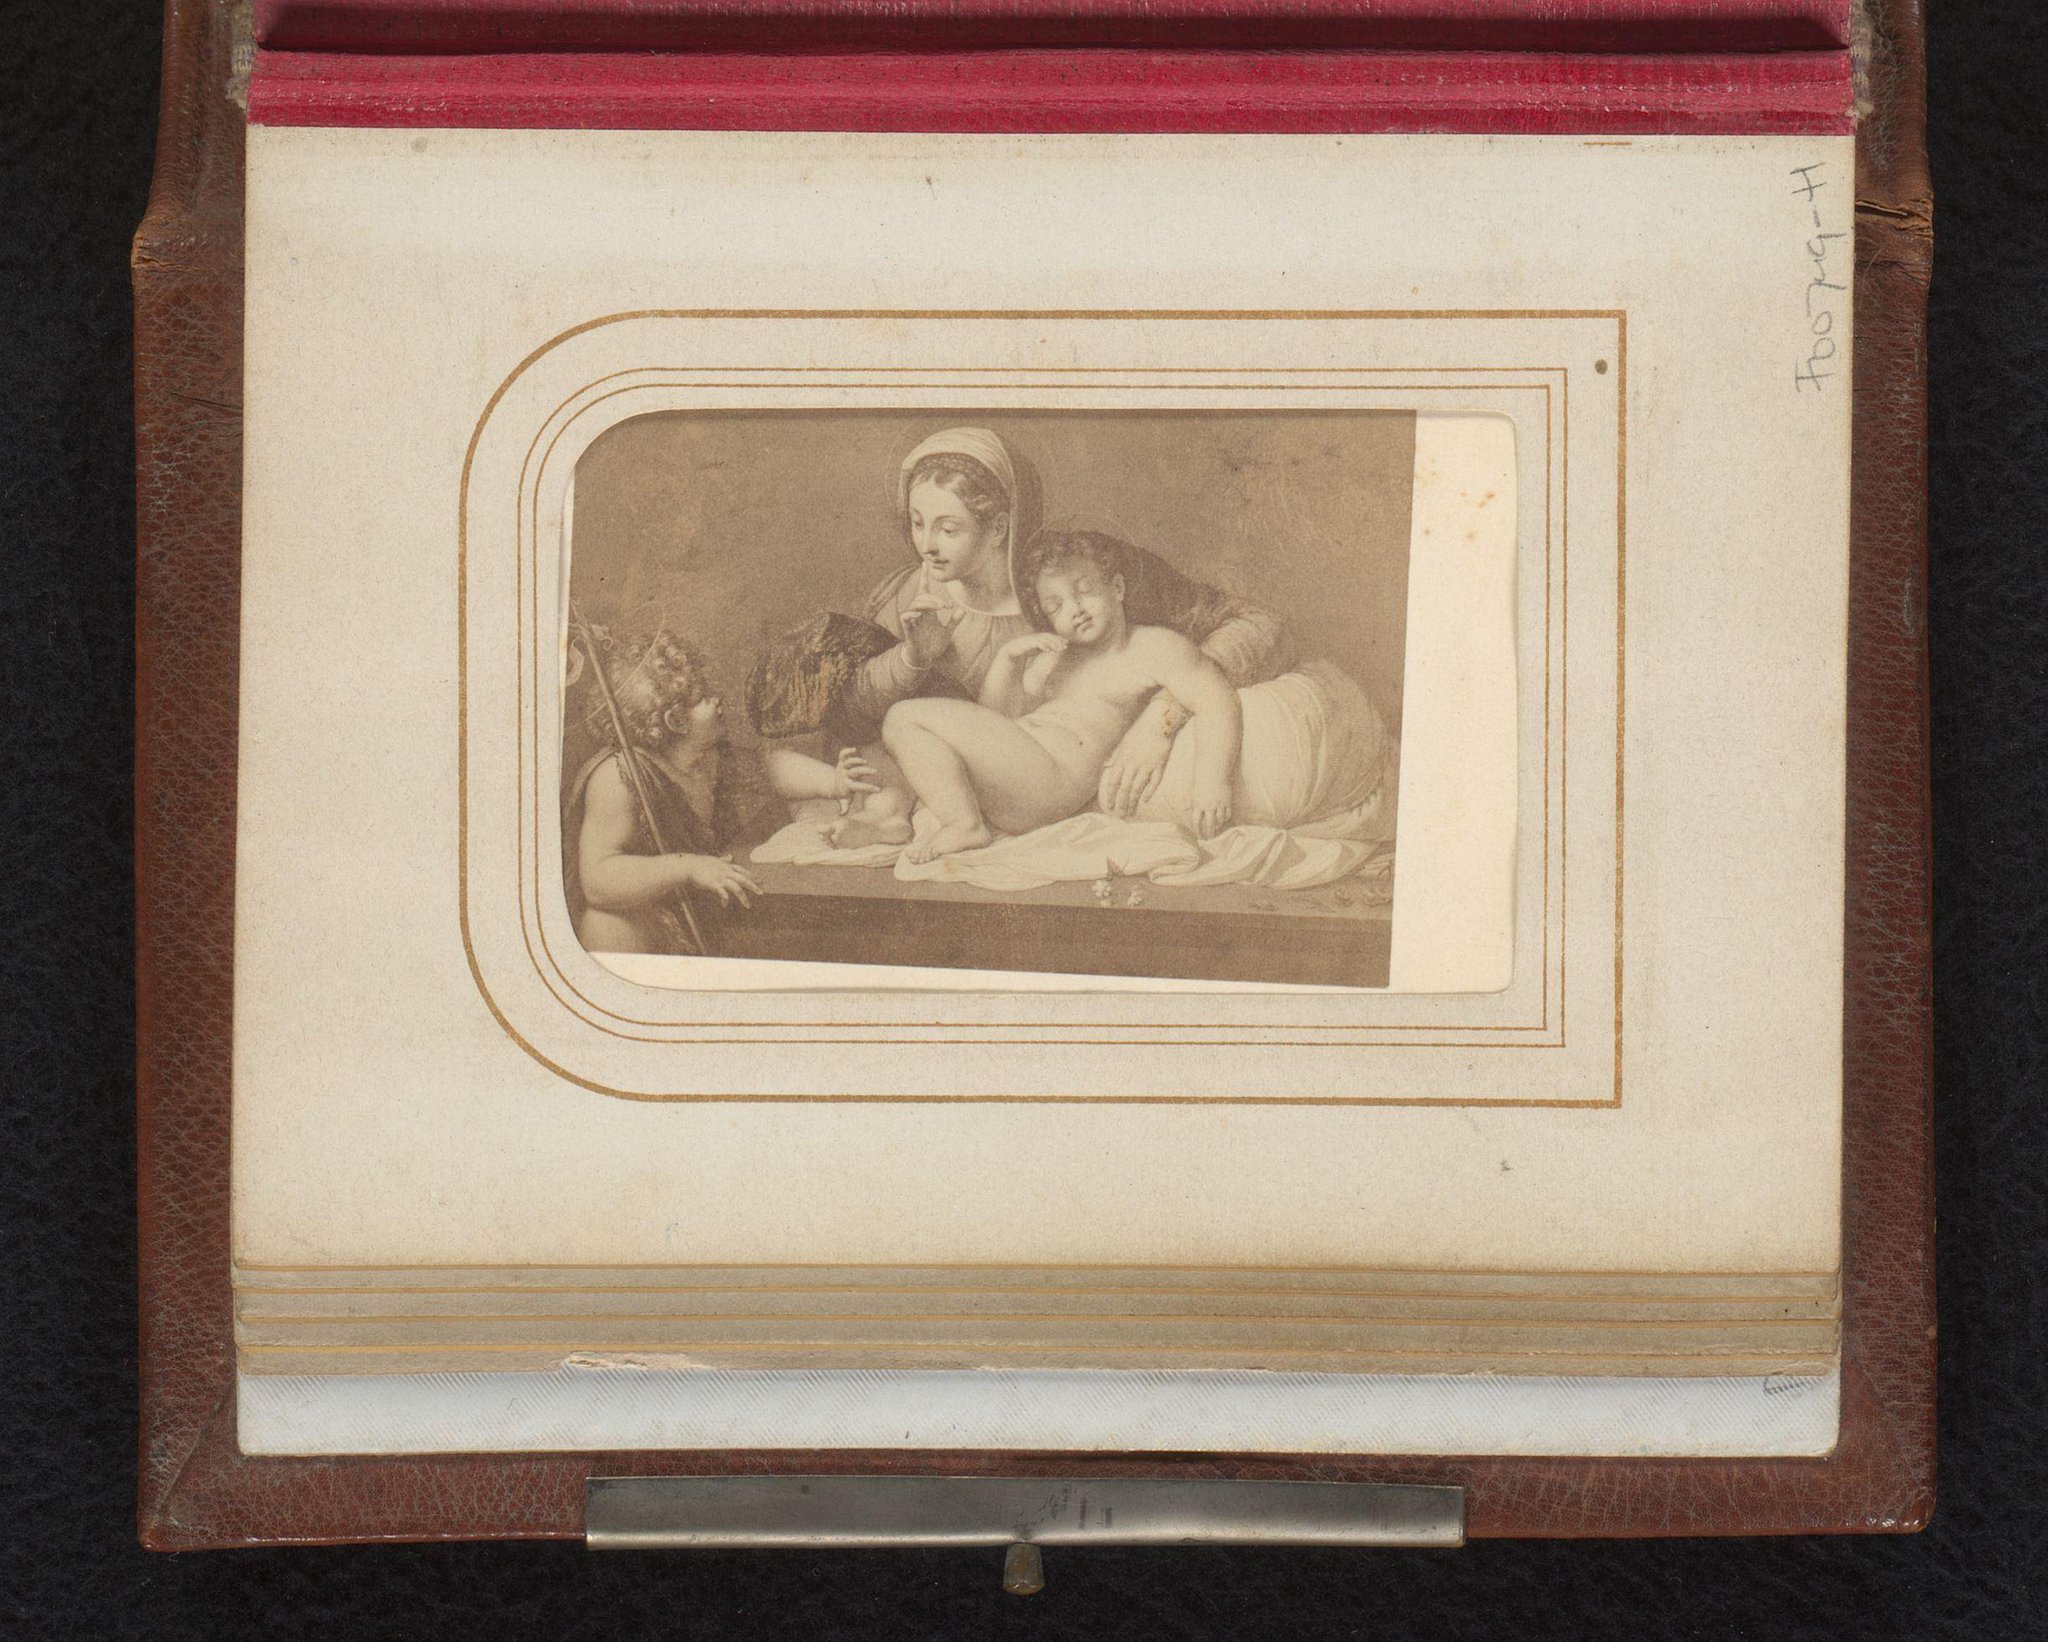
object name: carte de visite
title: Fotoreproductie van een prent naar Madonna del Silenzio door Annibale Carracci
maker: Anonymous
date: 1865-1900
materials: cardboard, photographic support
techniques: albumen print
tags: madonna: i.e. mary with the christ-child